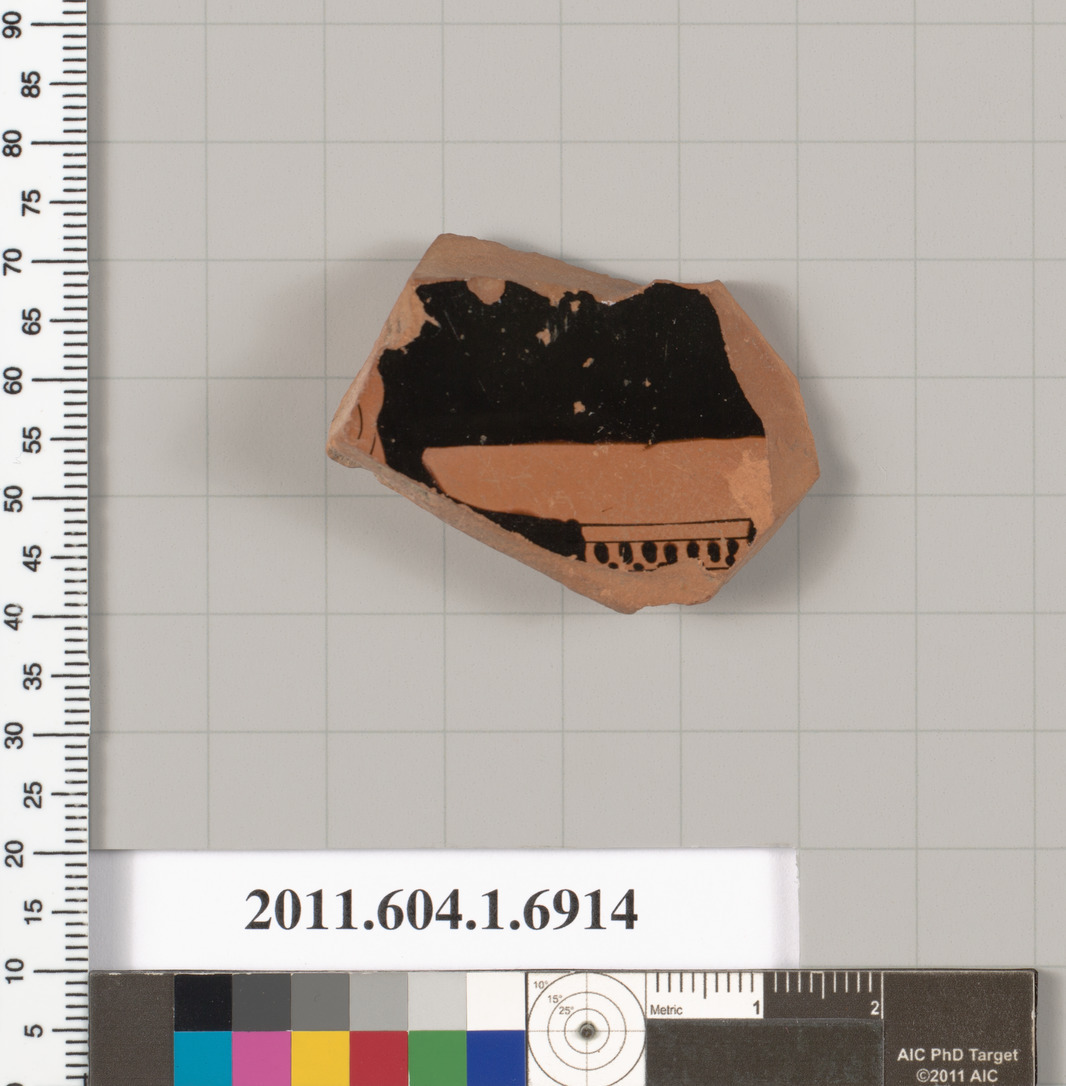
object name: kylix fragment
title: Terracotta fragment of a kylix (drinking cup)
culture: greek, attic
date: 490-470 BCE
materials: terracotta